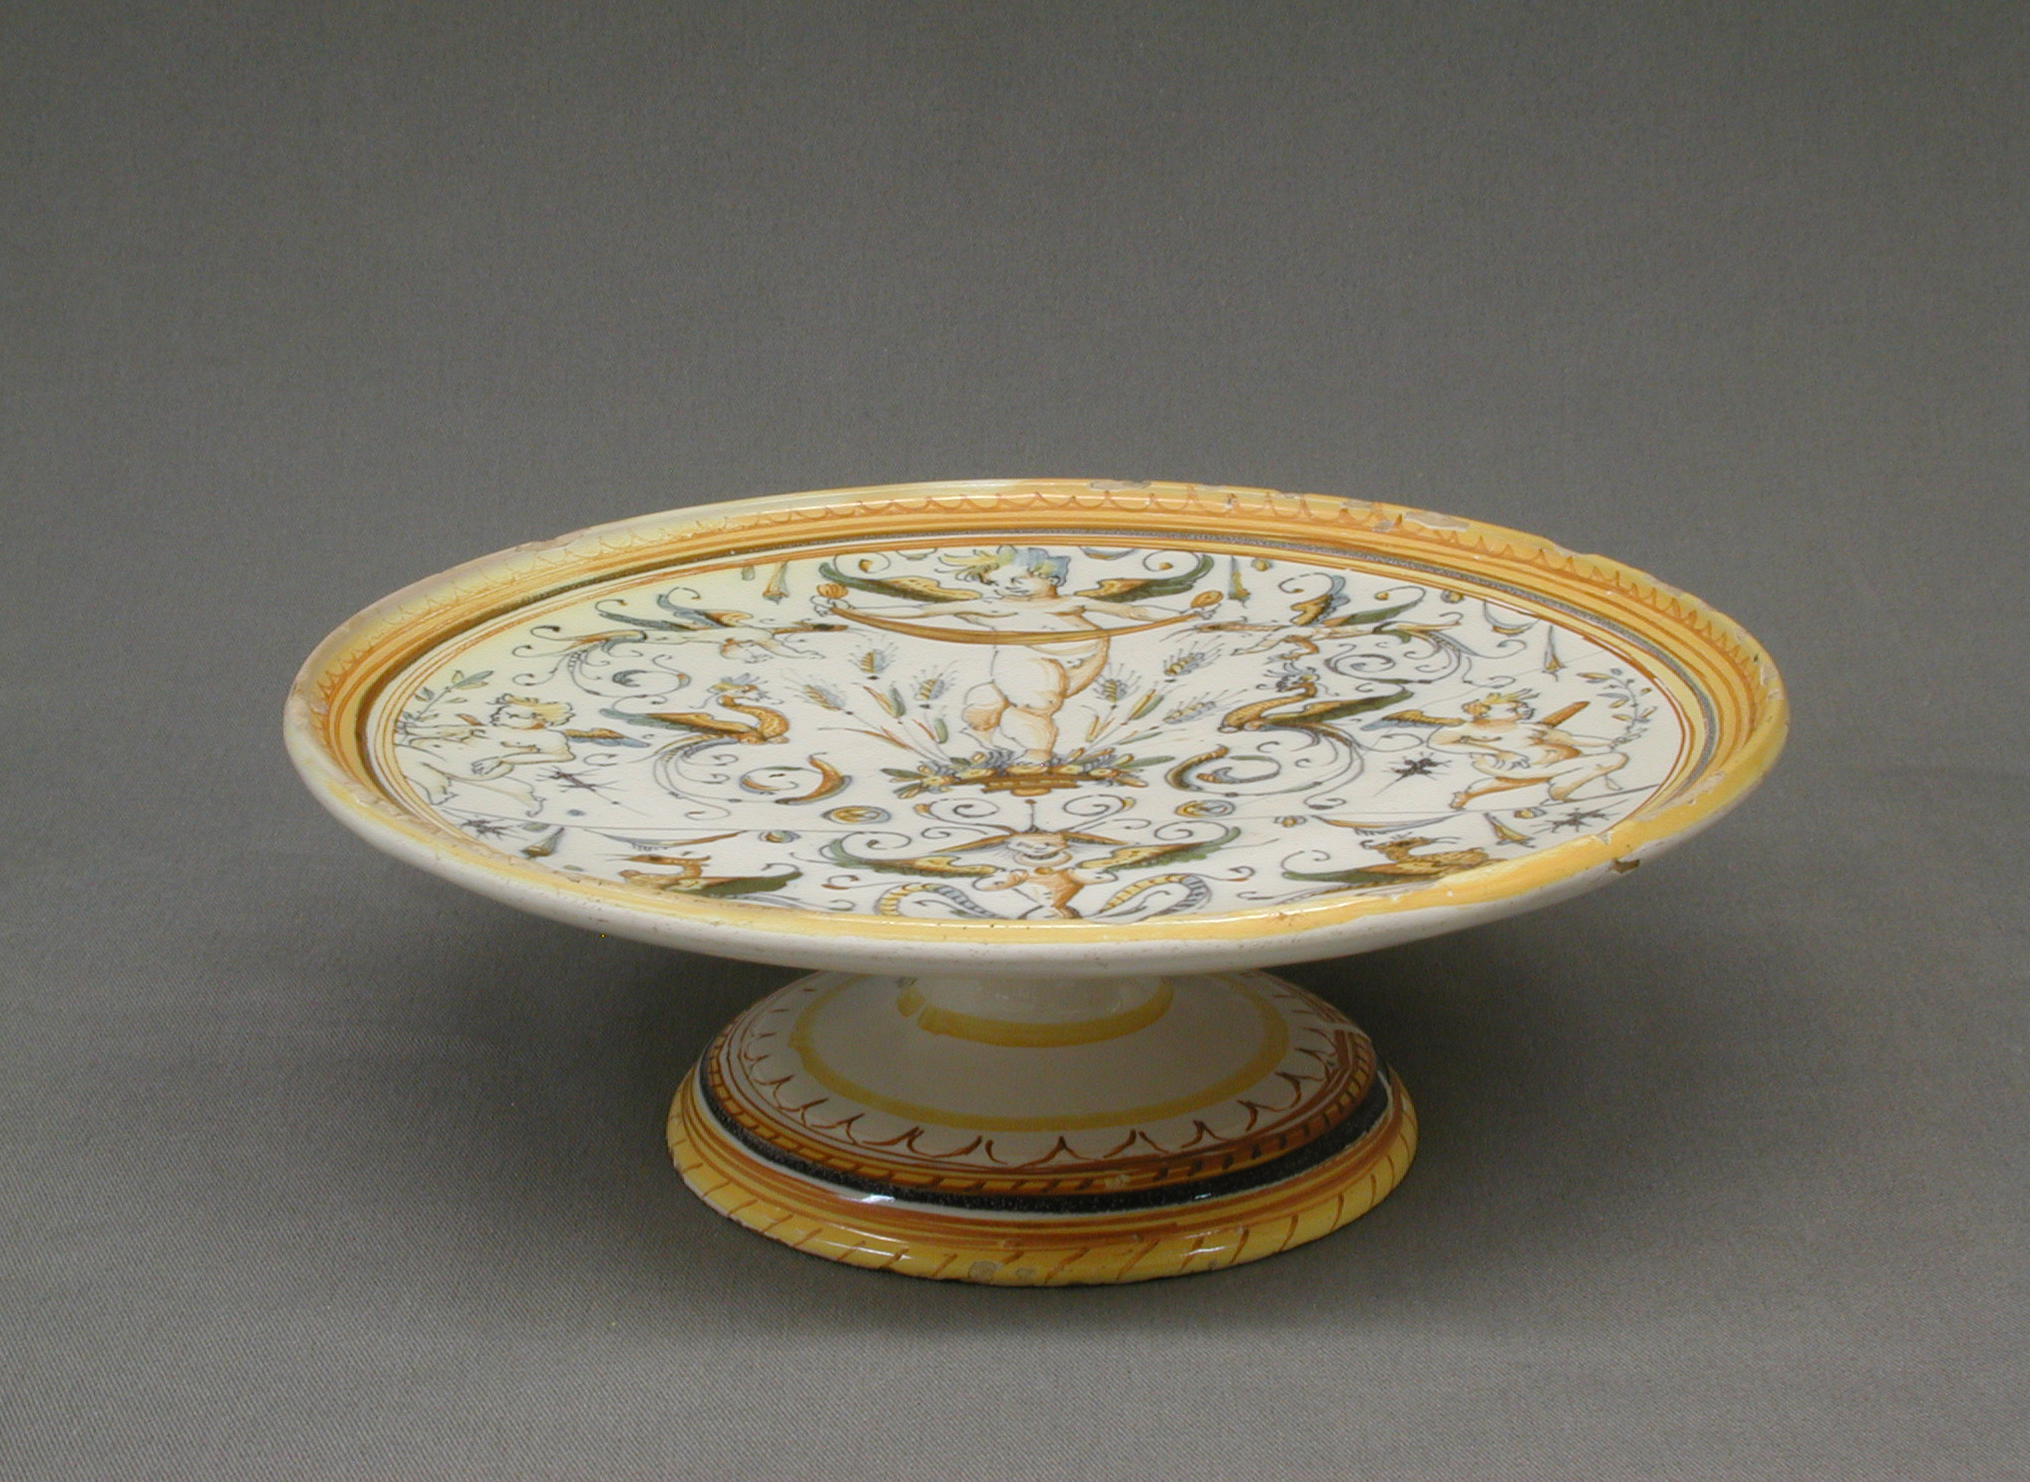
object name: tazza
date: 1600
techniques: maiolica, glazing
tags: cupid